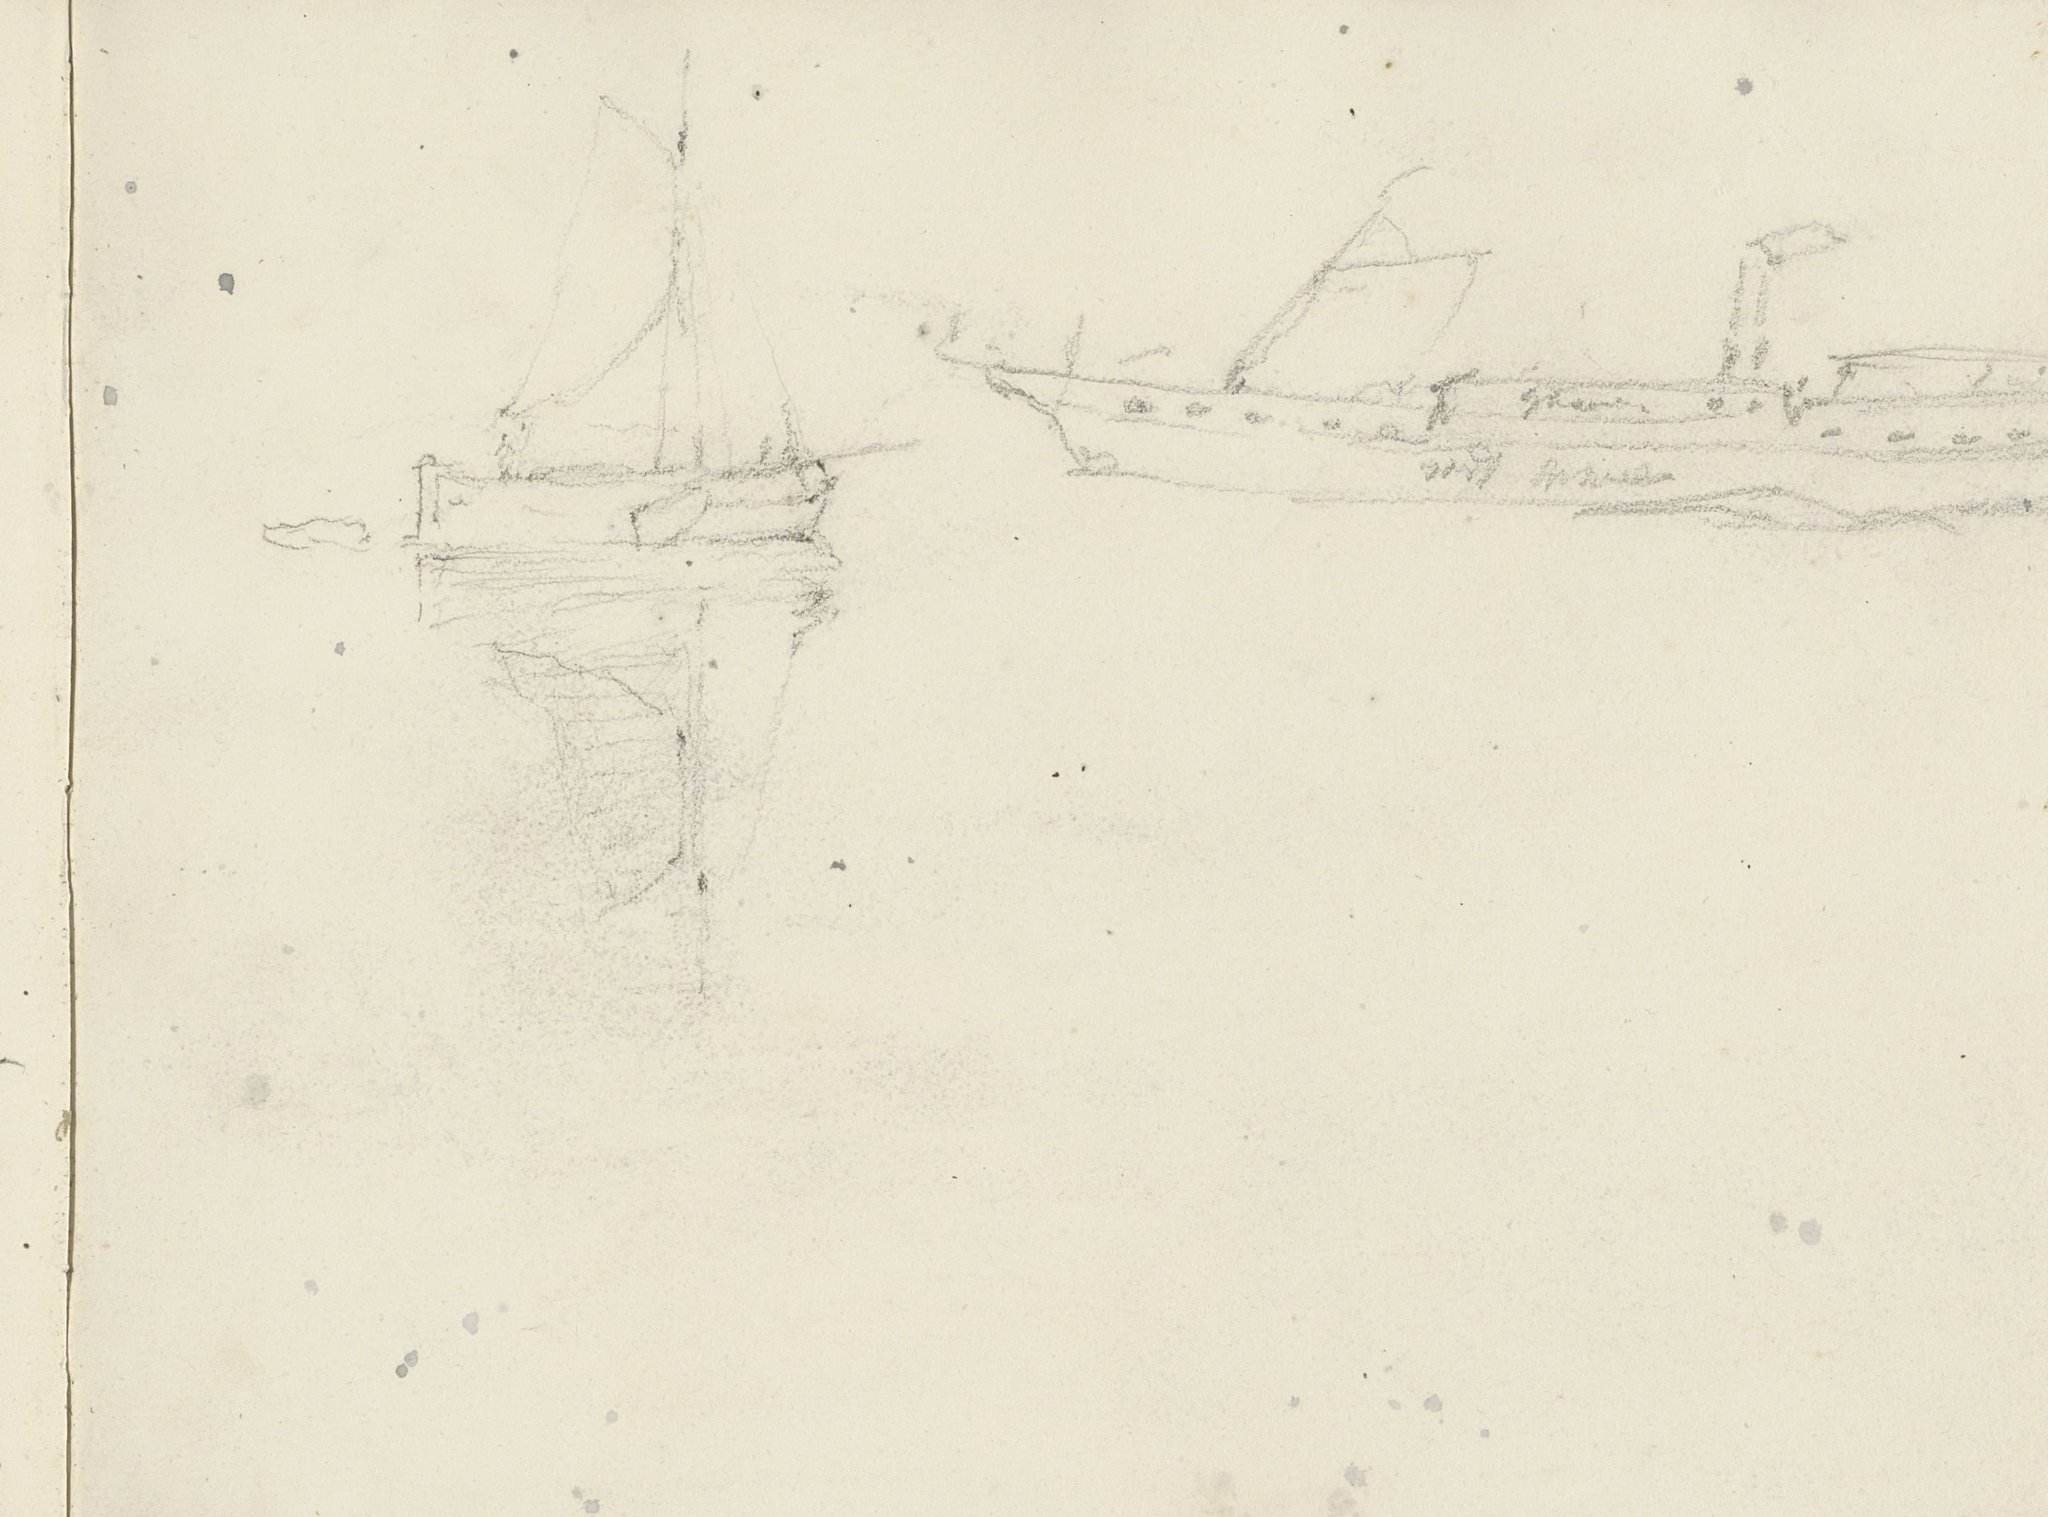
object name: sketchbook leaf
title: Zeilboot en stoomschip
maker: petrus johannes schotel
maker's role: draughtsman, painter, print maker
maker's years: 1808-1865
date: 1825-1875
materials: paper, pencil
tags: sailing-ship, sailing-boat, steamship, motorship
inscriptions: kleurnotitie, handgeschreven in potlood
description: Blad 29 recto uit een schetsboek met 44 bladen.